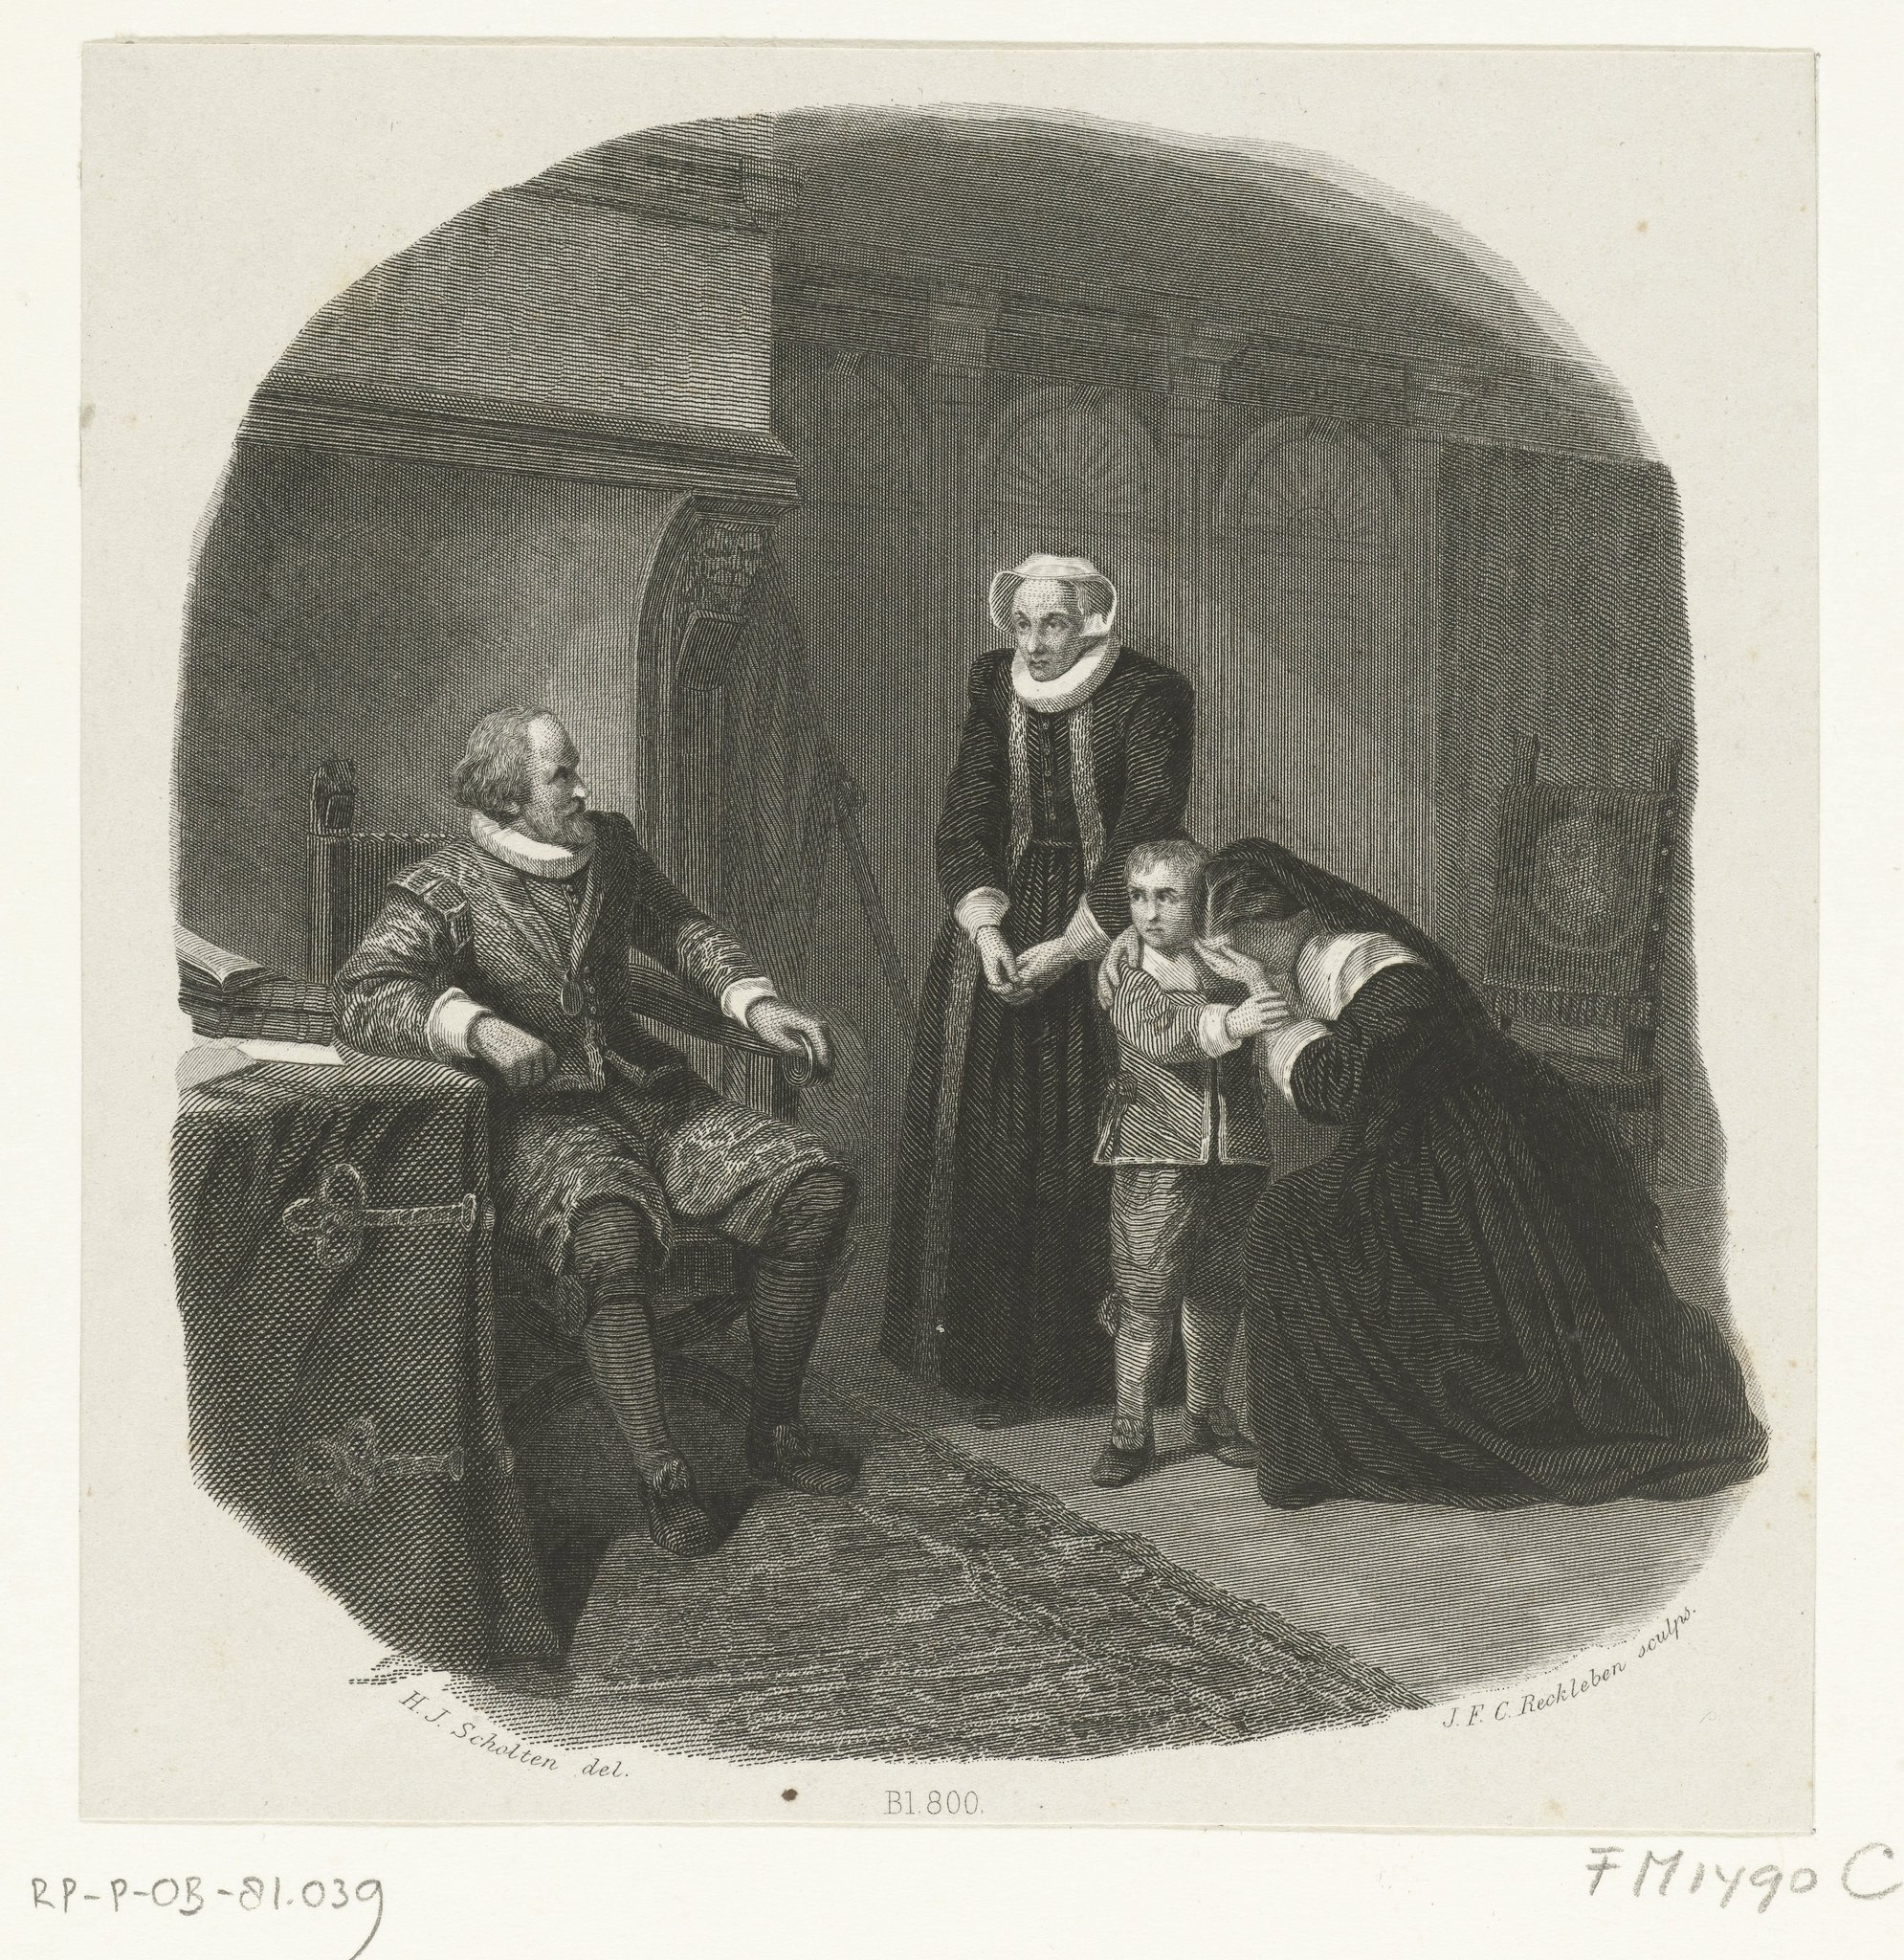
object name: print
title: De moeder, vrouw en zoon van Reinier van Oldenbarnevelt smeken Maurits om genade, 1623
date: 1861-1863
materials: paper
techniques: engraving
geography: netherlands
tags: the hague, maurice (prince of orange), (revolutionary) plot, conspiracy, granting mercy; free pardon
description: De moeder, vrouw en zoon van Reinier van Oldenbarnevelt bij prins Maurits gezeten aan een tafel smeken om genade voor Reinier van Oldenbarnevelt, één van de ter dood veroordeelde samenzweerders, maart 1623.